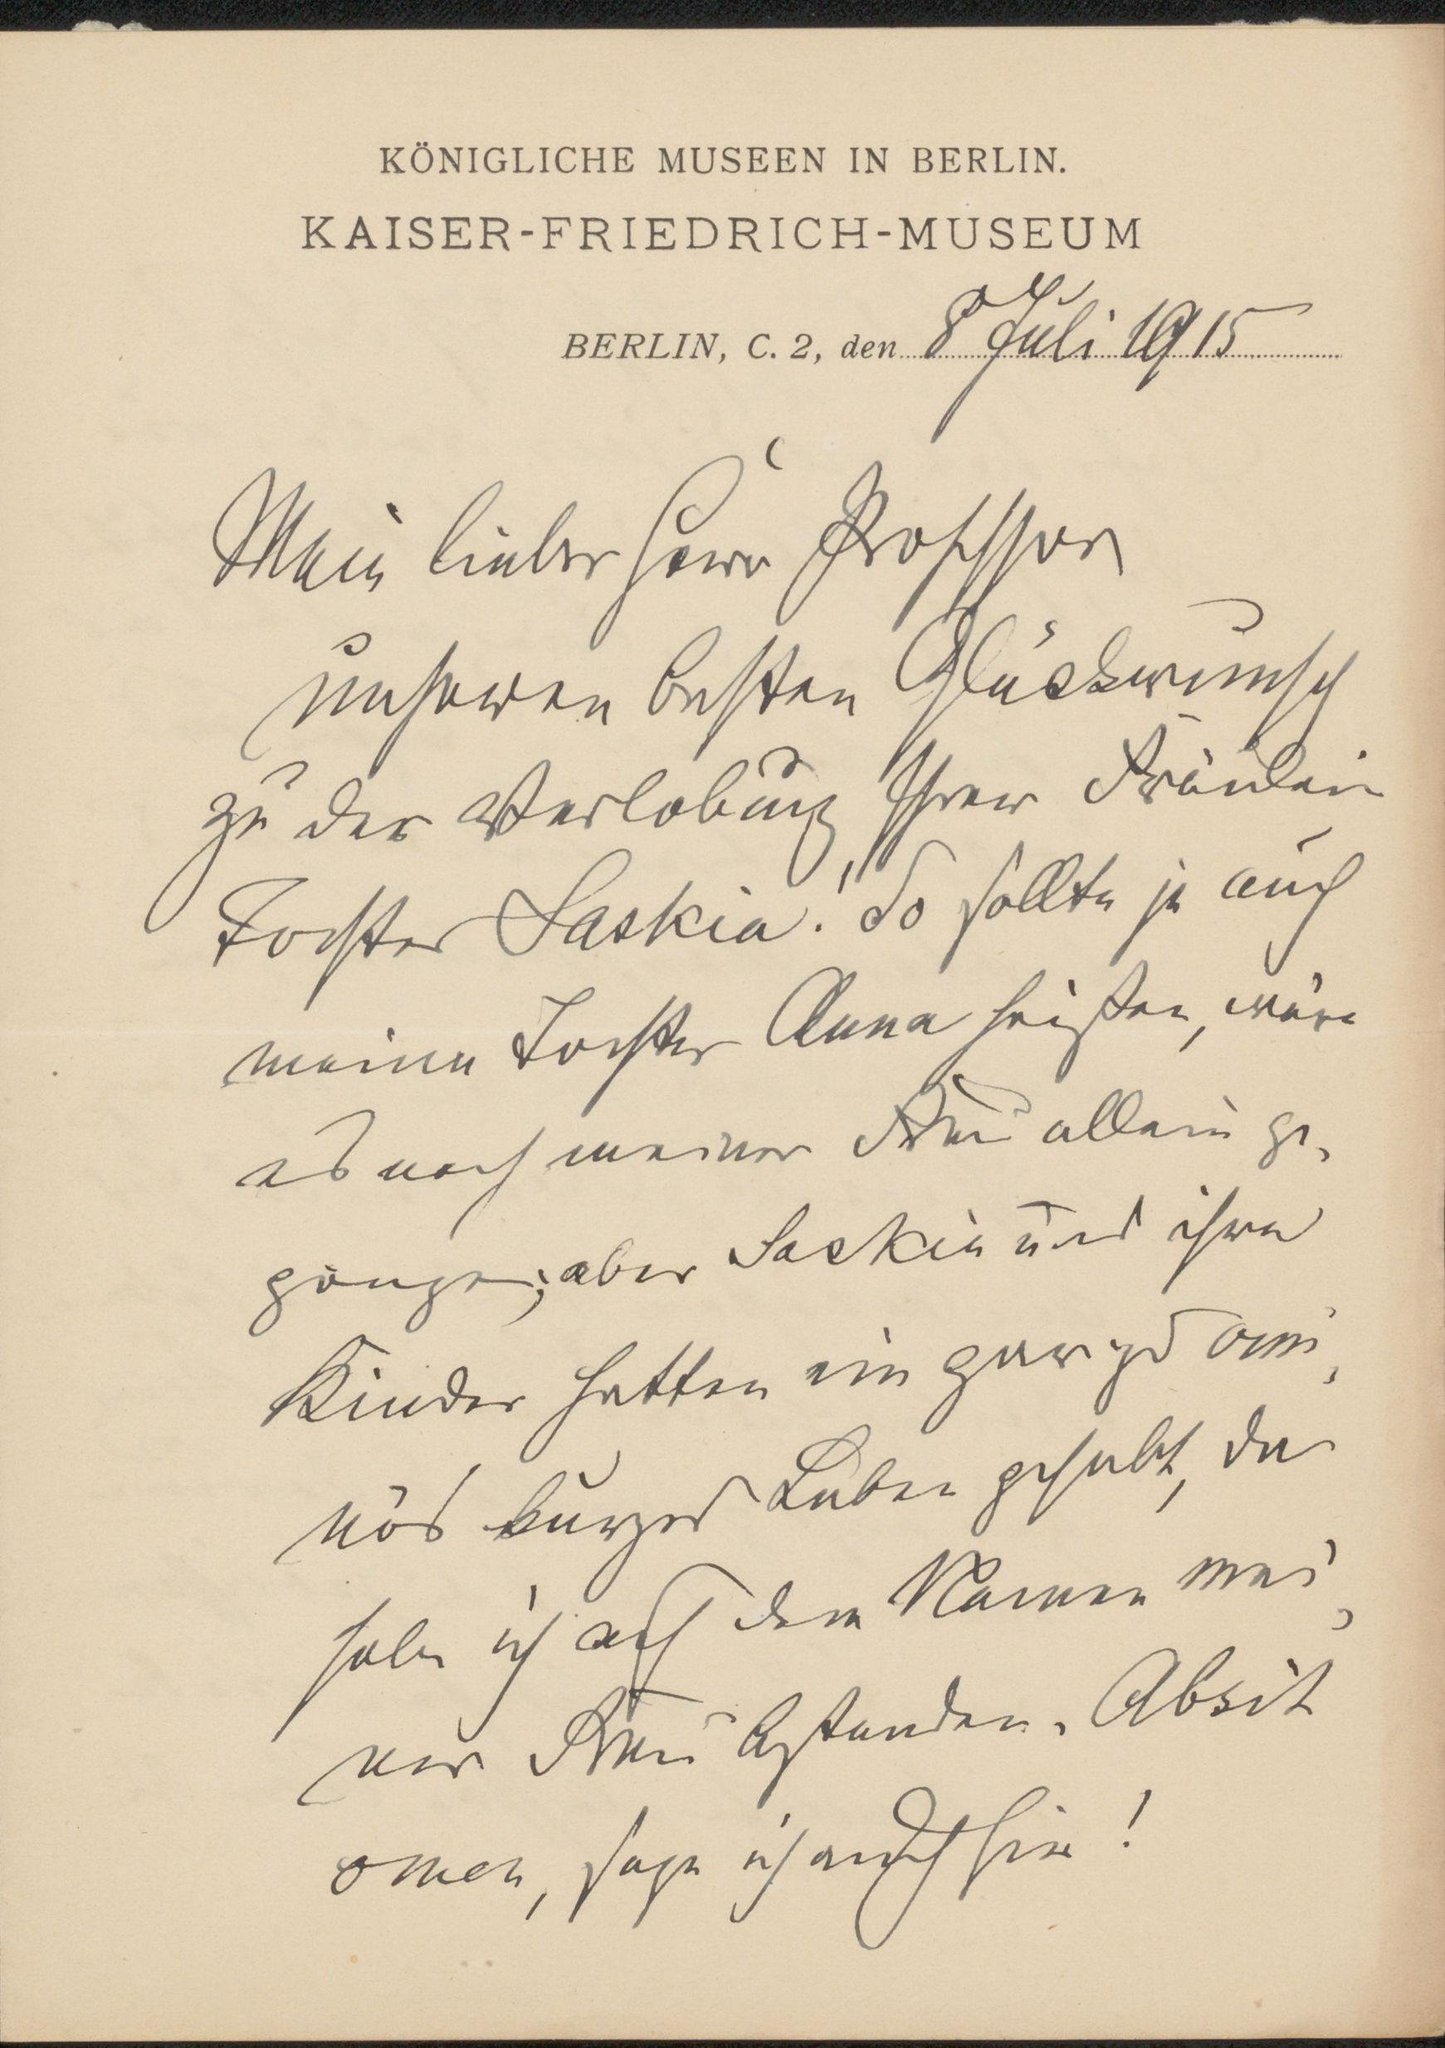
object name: letter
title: Brief aan Jan Veth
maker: wilhelm von bode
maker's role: conservator, kunsthistoricus, museumdirecteur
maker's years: 1845-1929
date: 1915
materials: ink, paper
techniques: pen, printing, writing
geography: berlin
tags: dordrecht, amsterdam, painter, print maker, draughtsman, designer, jan veth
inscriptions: collector's mark: ‘RPK’